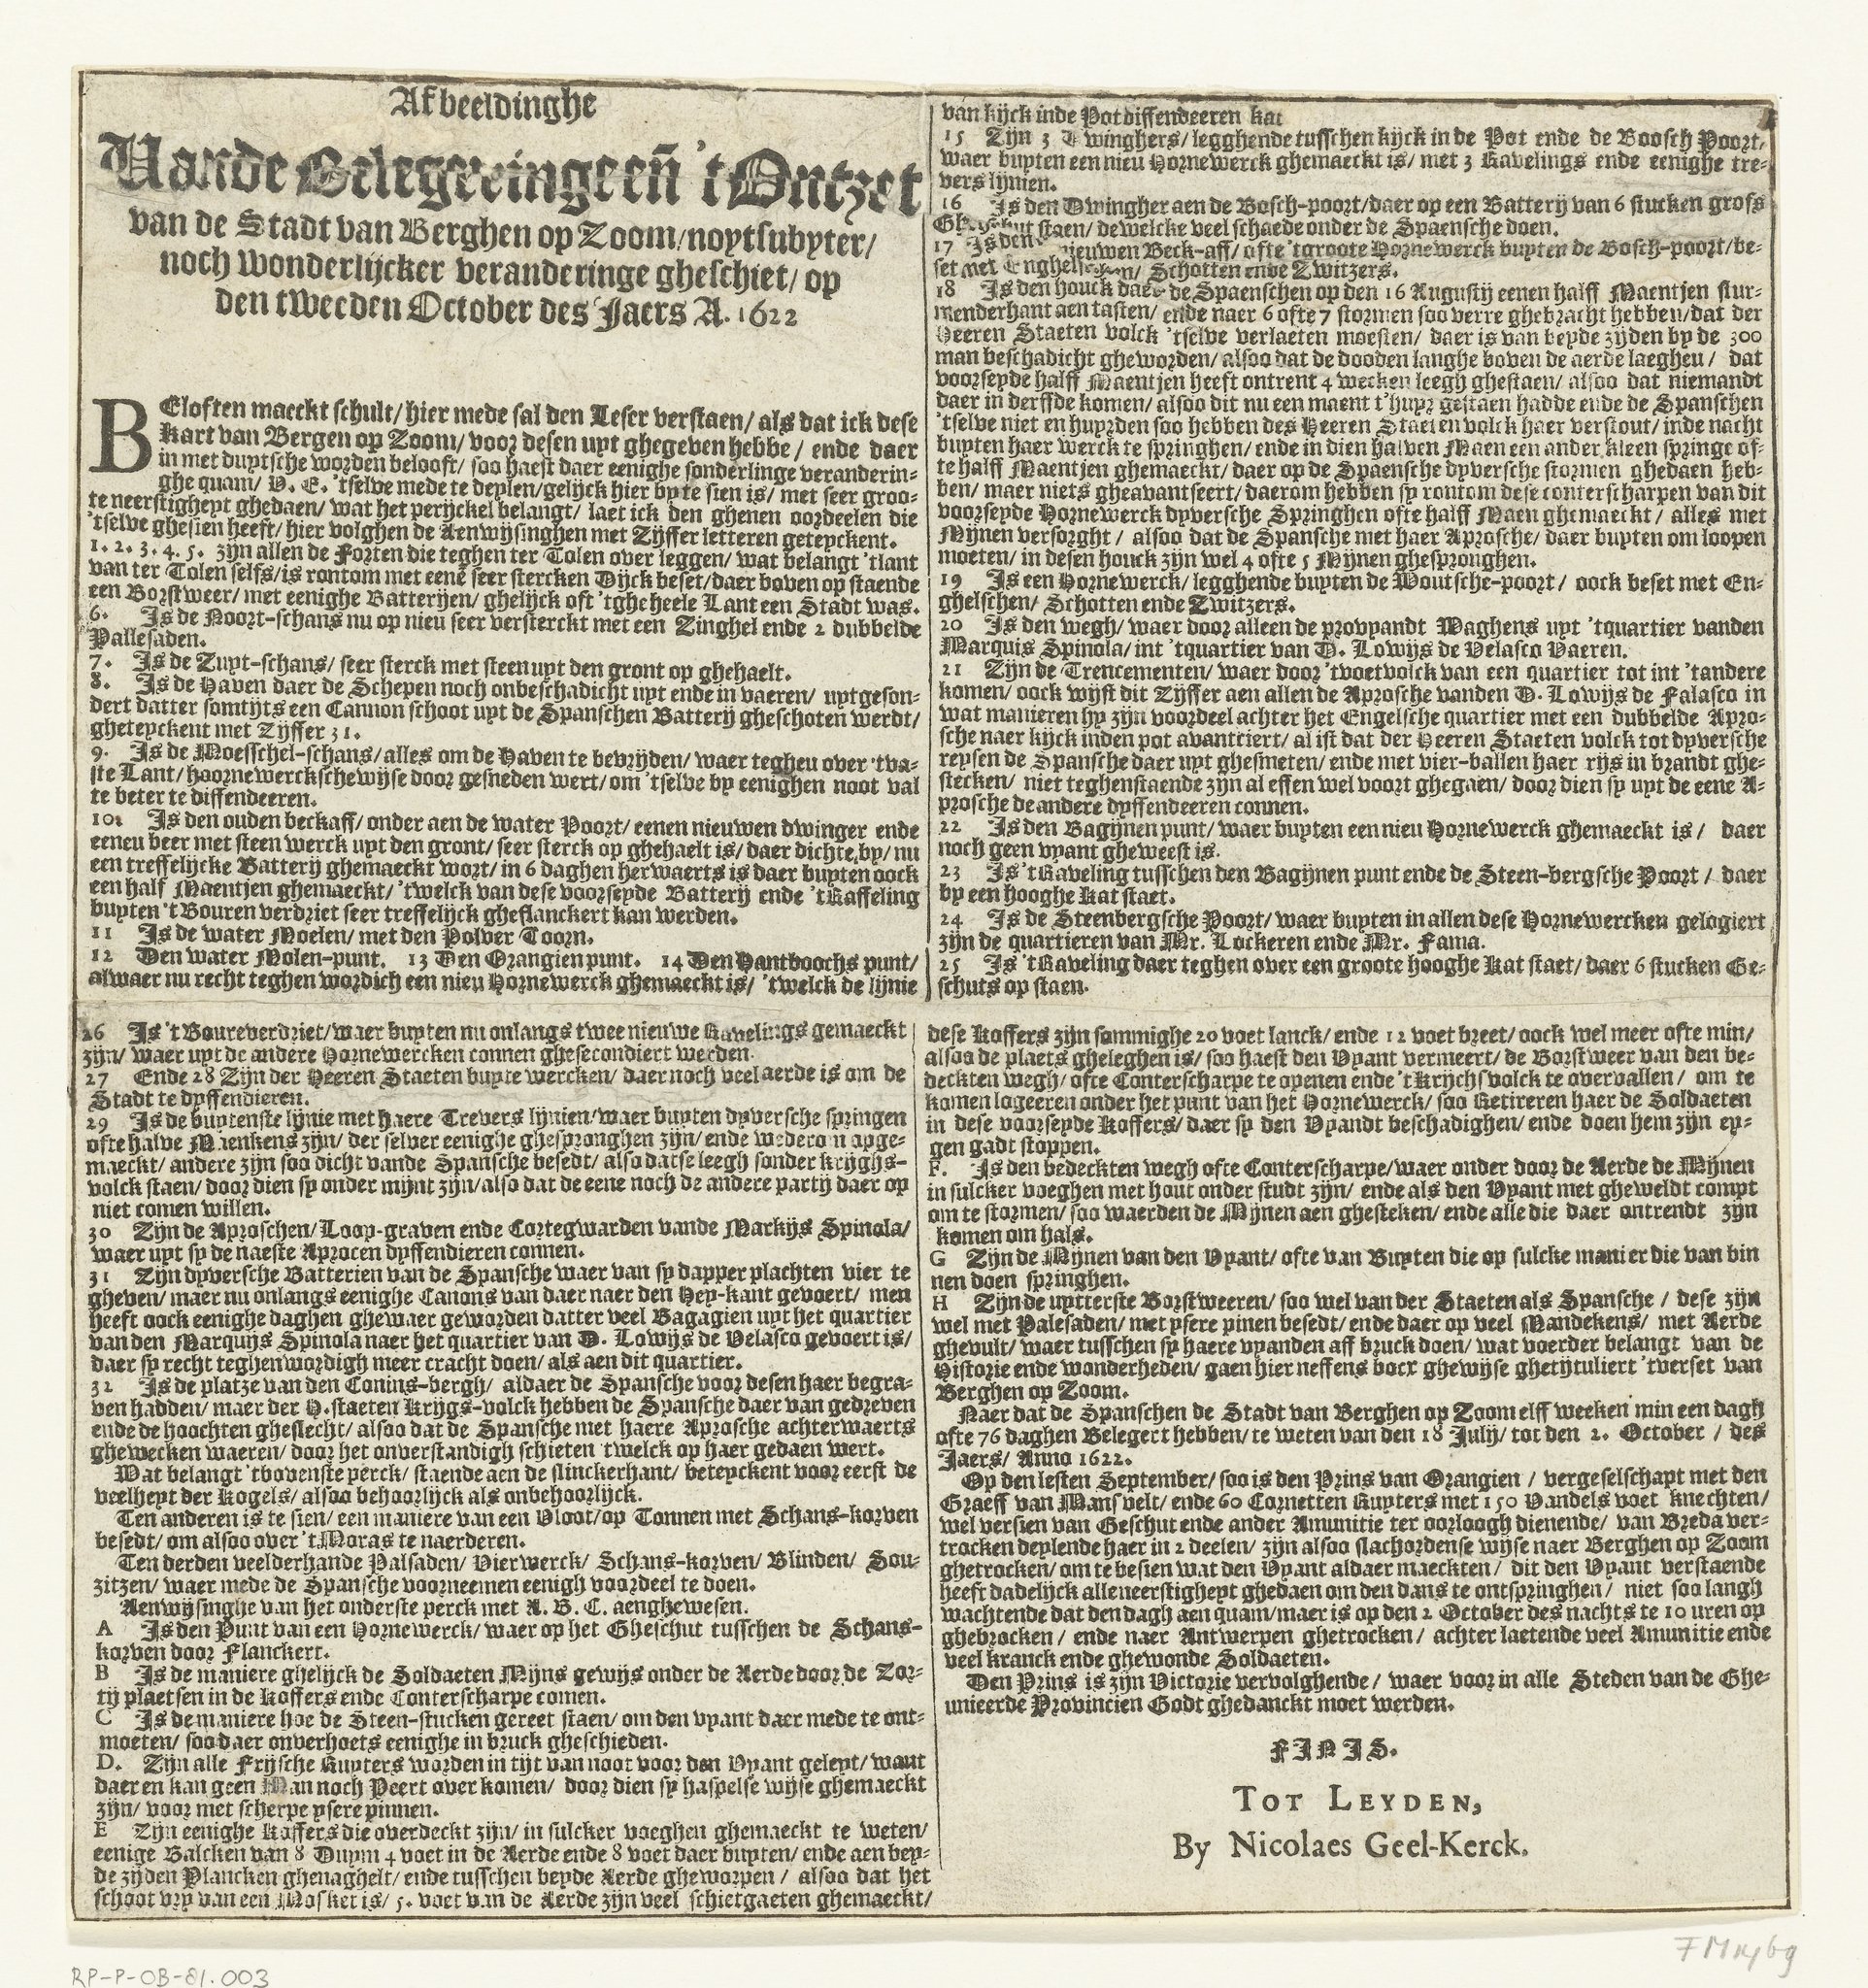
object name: print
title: Afbeeldinghe Vande Belegeringe en[de] 't Ontzet van de Stadt van Berghen op Zoom / noyt subyter / noch wonderlijcker veranderinge gheschiet / op den tweeden October des Jaers A. 1622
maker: nicolaes van geelkercken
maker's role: print maker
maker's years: 1585-1656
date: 1622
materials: paper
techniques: letterpress printing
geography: leiden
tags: bergen op zoom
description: Tekstblad behorend bij een (ontbrekende) prent van het mislukte beleg van Bergen op Zoom door het Spaanse leger onder Spinola en Velasco, 18 juli - 3 oktober 1622. Tekst in 2 kolommen in het Nederlands.